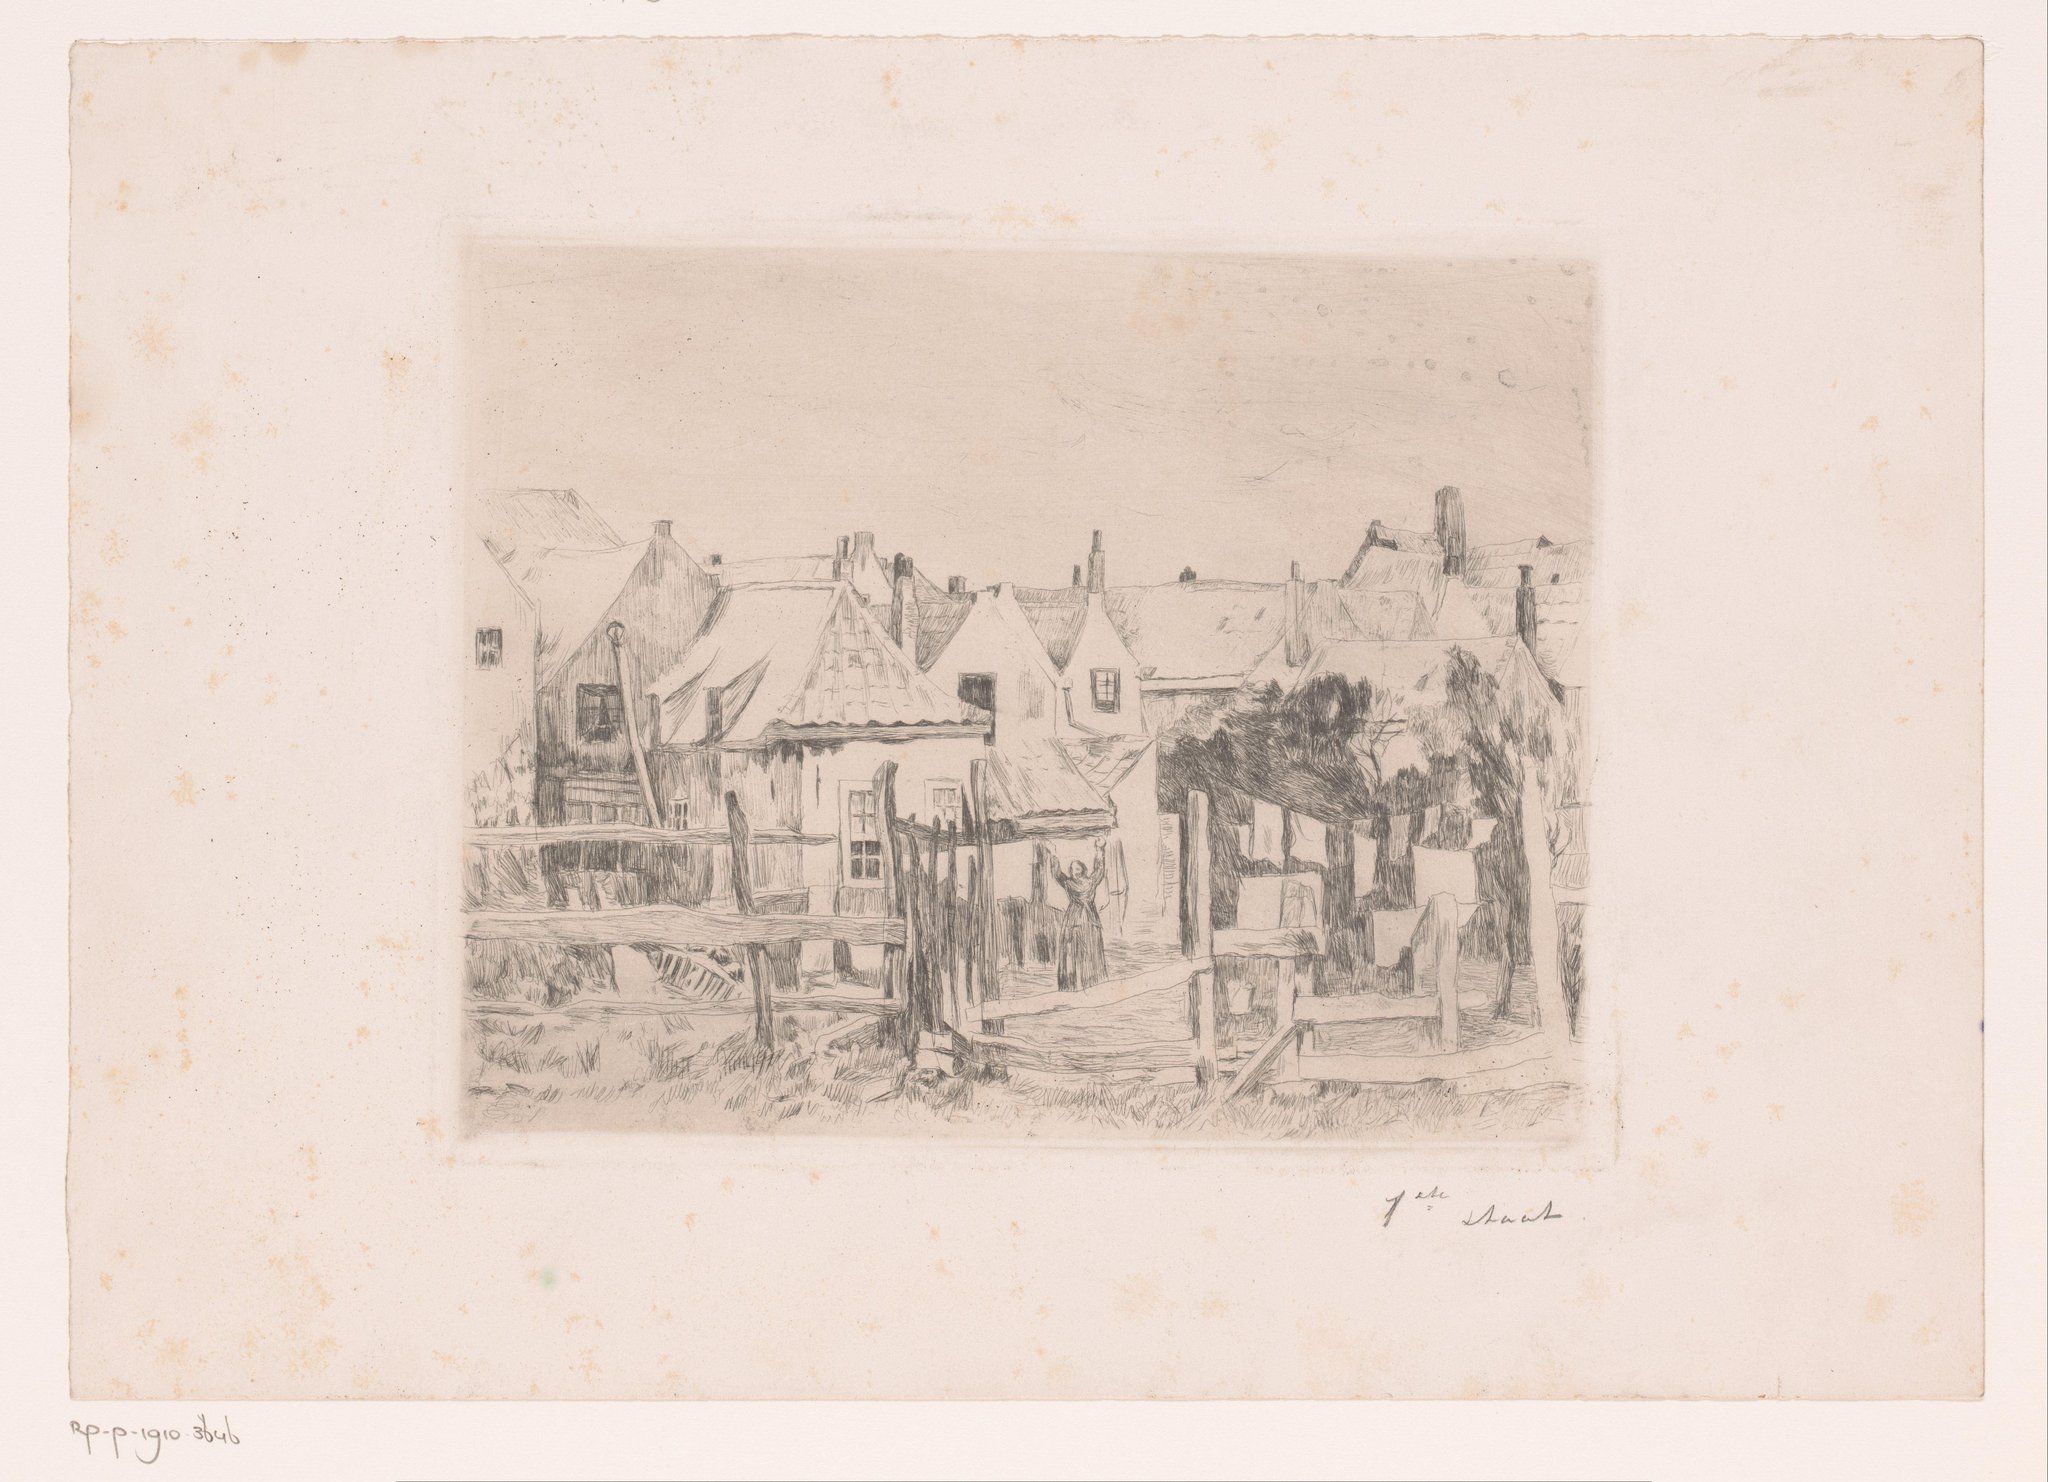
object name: print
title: Bij een dorp hangt een vrouw was aan de lijn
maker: léopold haeck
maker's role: painter, print maker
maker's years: 1868-1928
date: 1878-1910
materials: paper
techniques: etching, intaglio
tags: prospect of village, silhouette of village, hanging the wash to dry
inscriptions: collector's mark: Lugt 2228, annotation: ‘1ste staat’